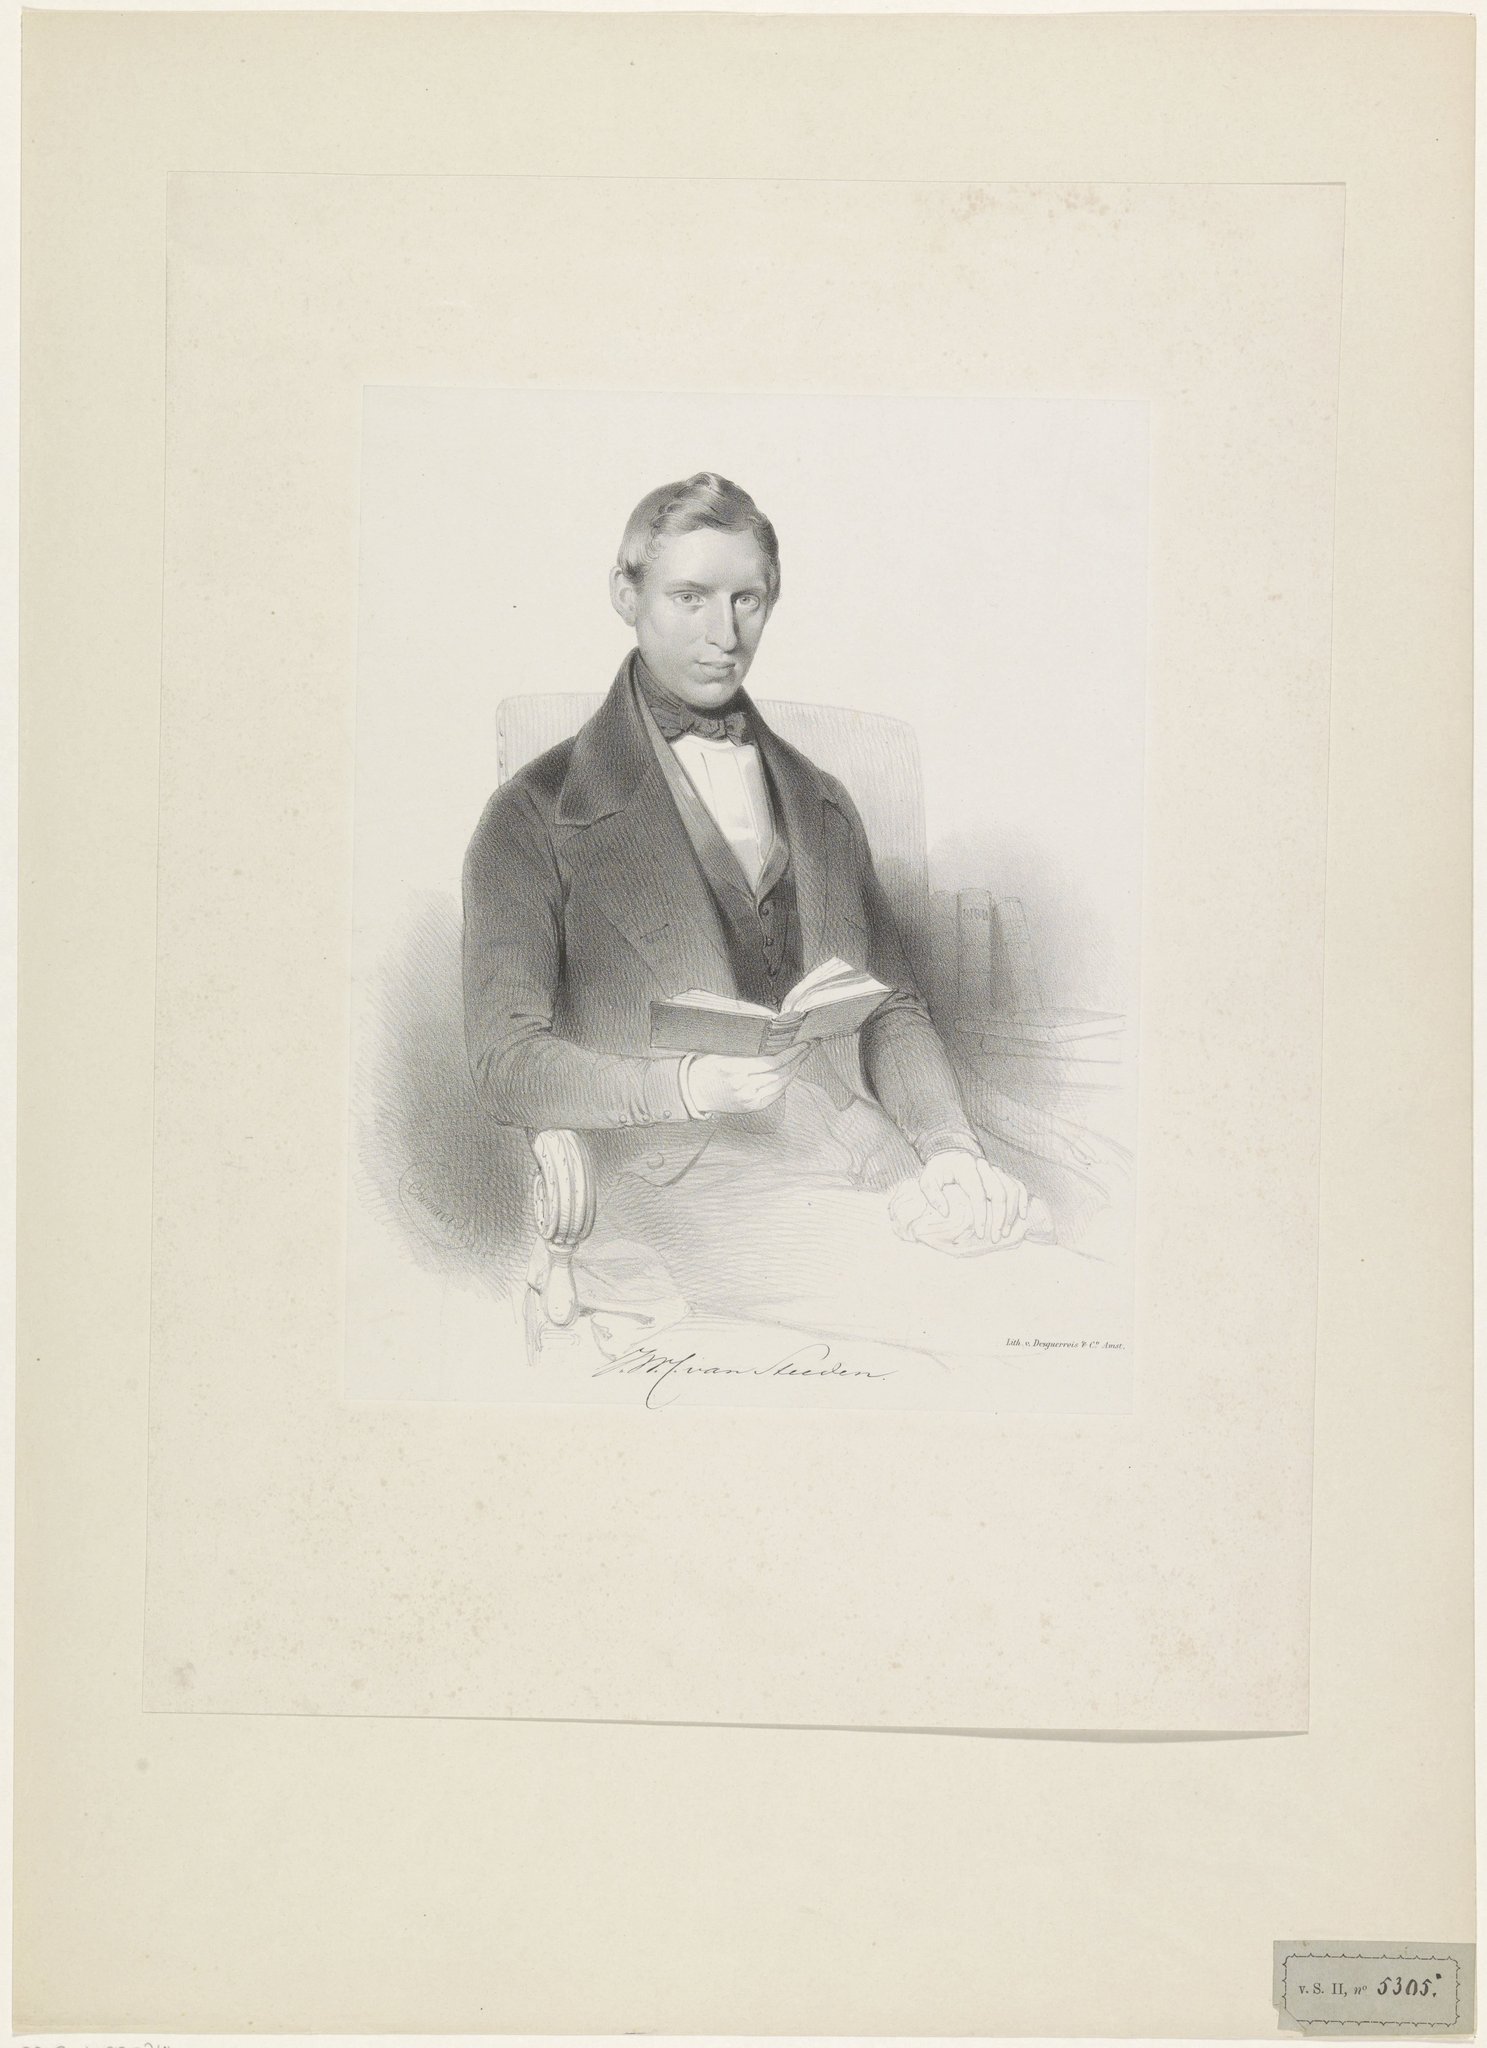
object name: print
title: Portret van J.W.C. van Steeden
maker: wilhelmus cornelis chimaer van oudendorp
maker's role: print maker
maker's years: 1822-1873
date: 1832-1873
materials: paper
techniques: lithograph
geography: netherlands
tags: handkerchief, book - mm - book open, historical persons (+ half-length portrait)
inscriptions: collector's mark: Lugt 2228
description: De geportretteerde zit in een stoel. In zijn rechterhand heeft hij een open boek, in zijn linkerhand een zakdoek. Rechts van hem staan en liggen boeken. Onder het portret zijn signatuur.